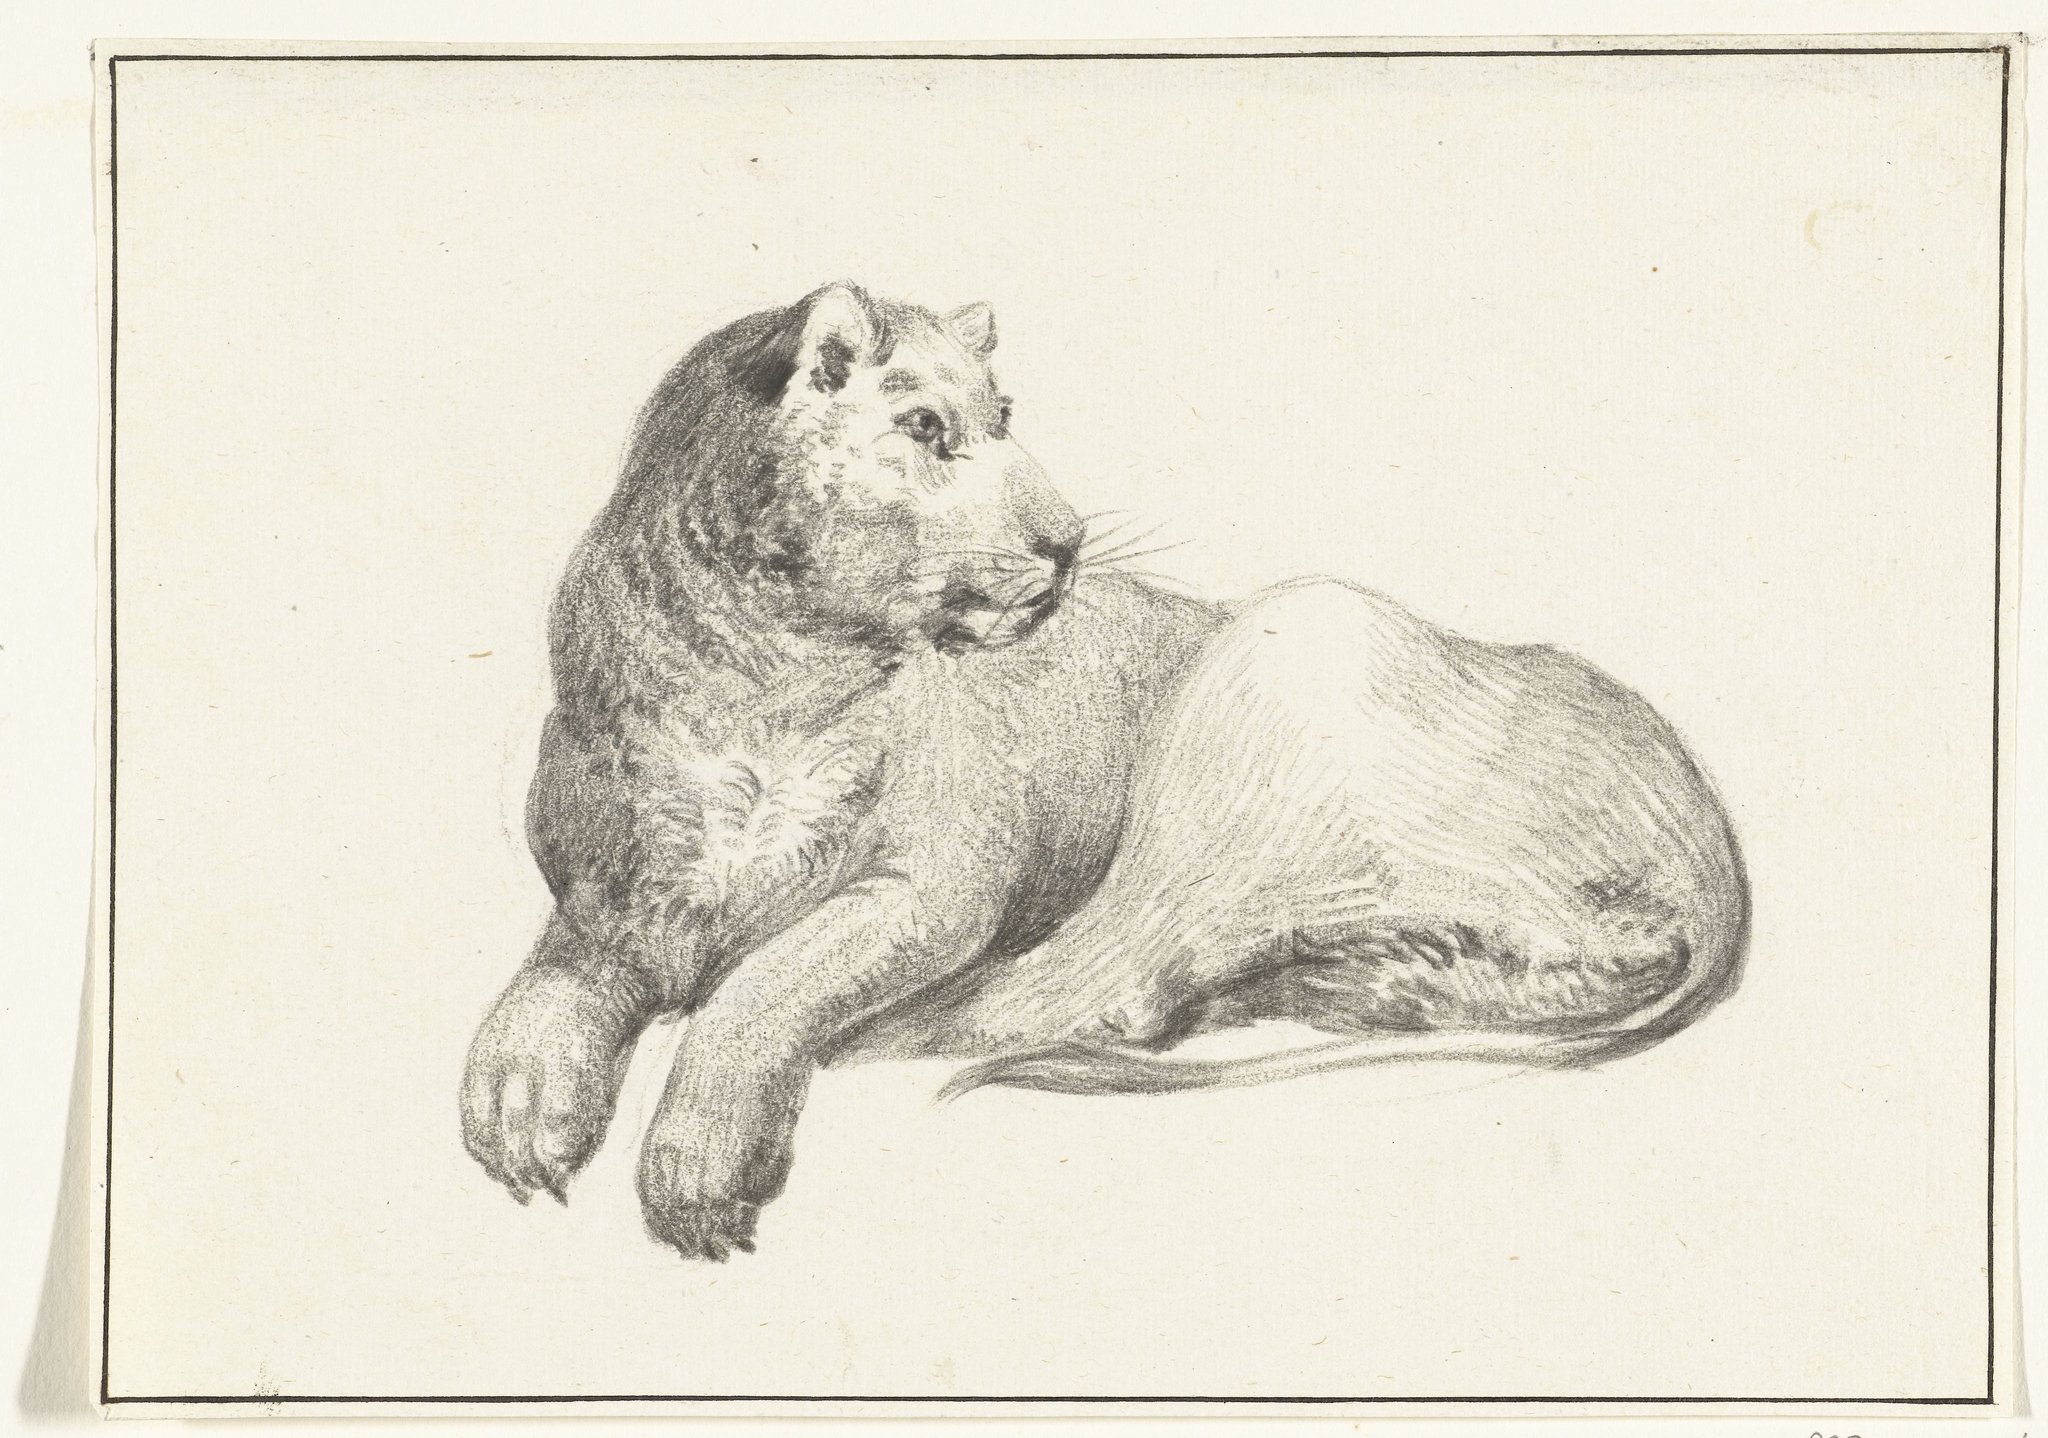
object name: drawing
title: Liggende leeuw, de kop naar rechts gedraaid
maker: jean bernard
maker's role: draughtsman, print maker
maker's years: 1765-1833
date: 1775-1833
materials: chalk, paper, pencil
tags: beasts of prey, predatory animals: lion